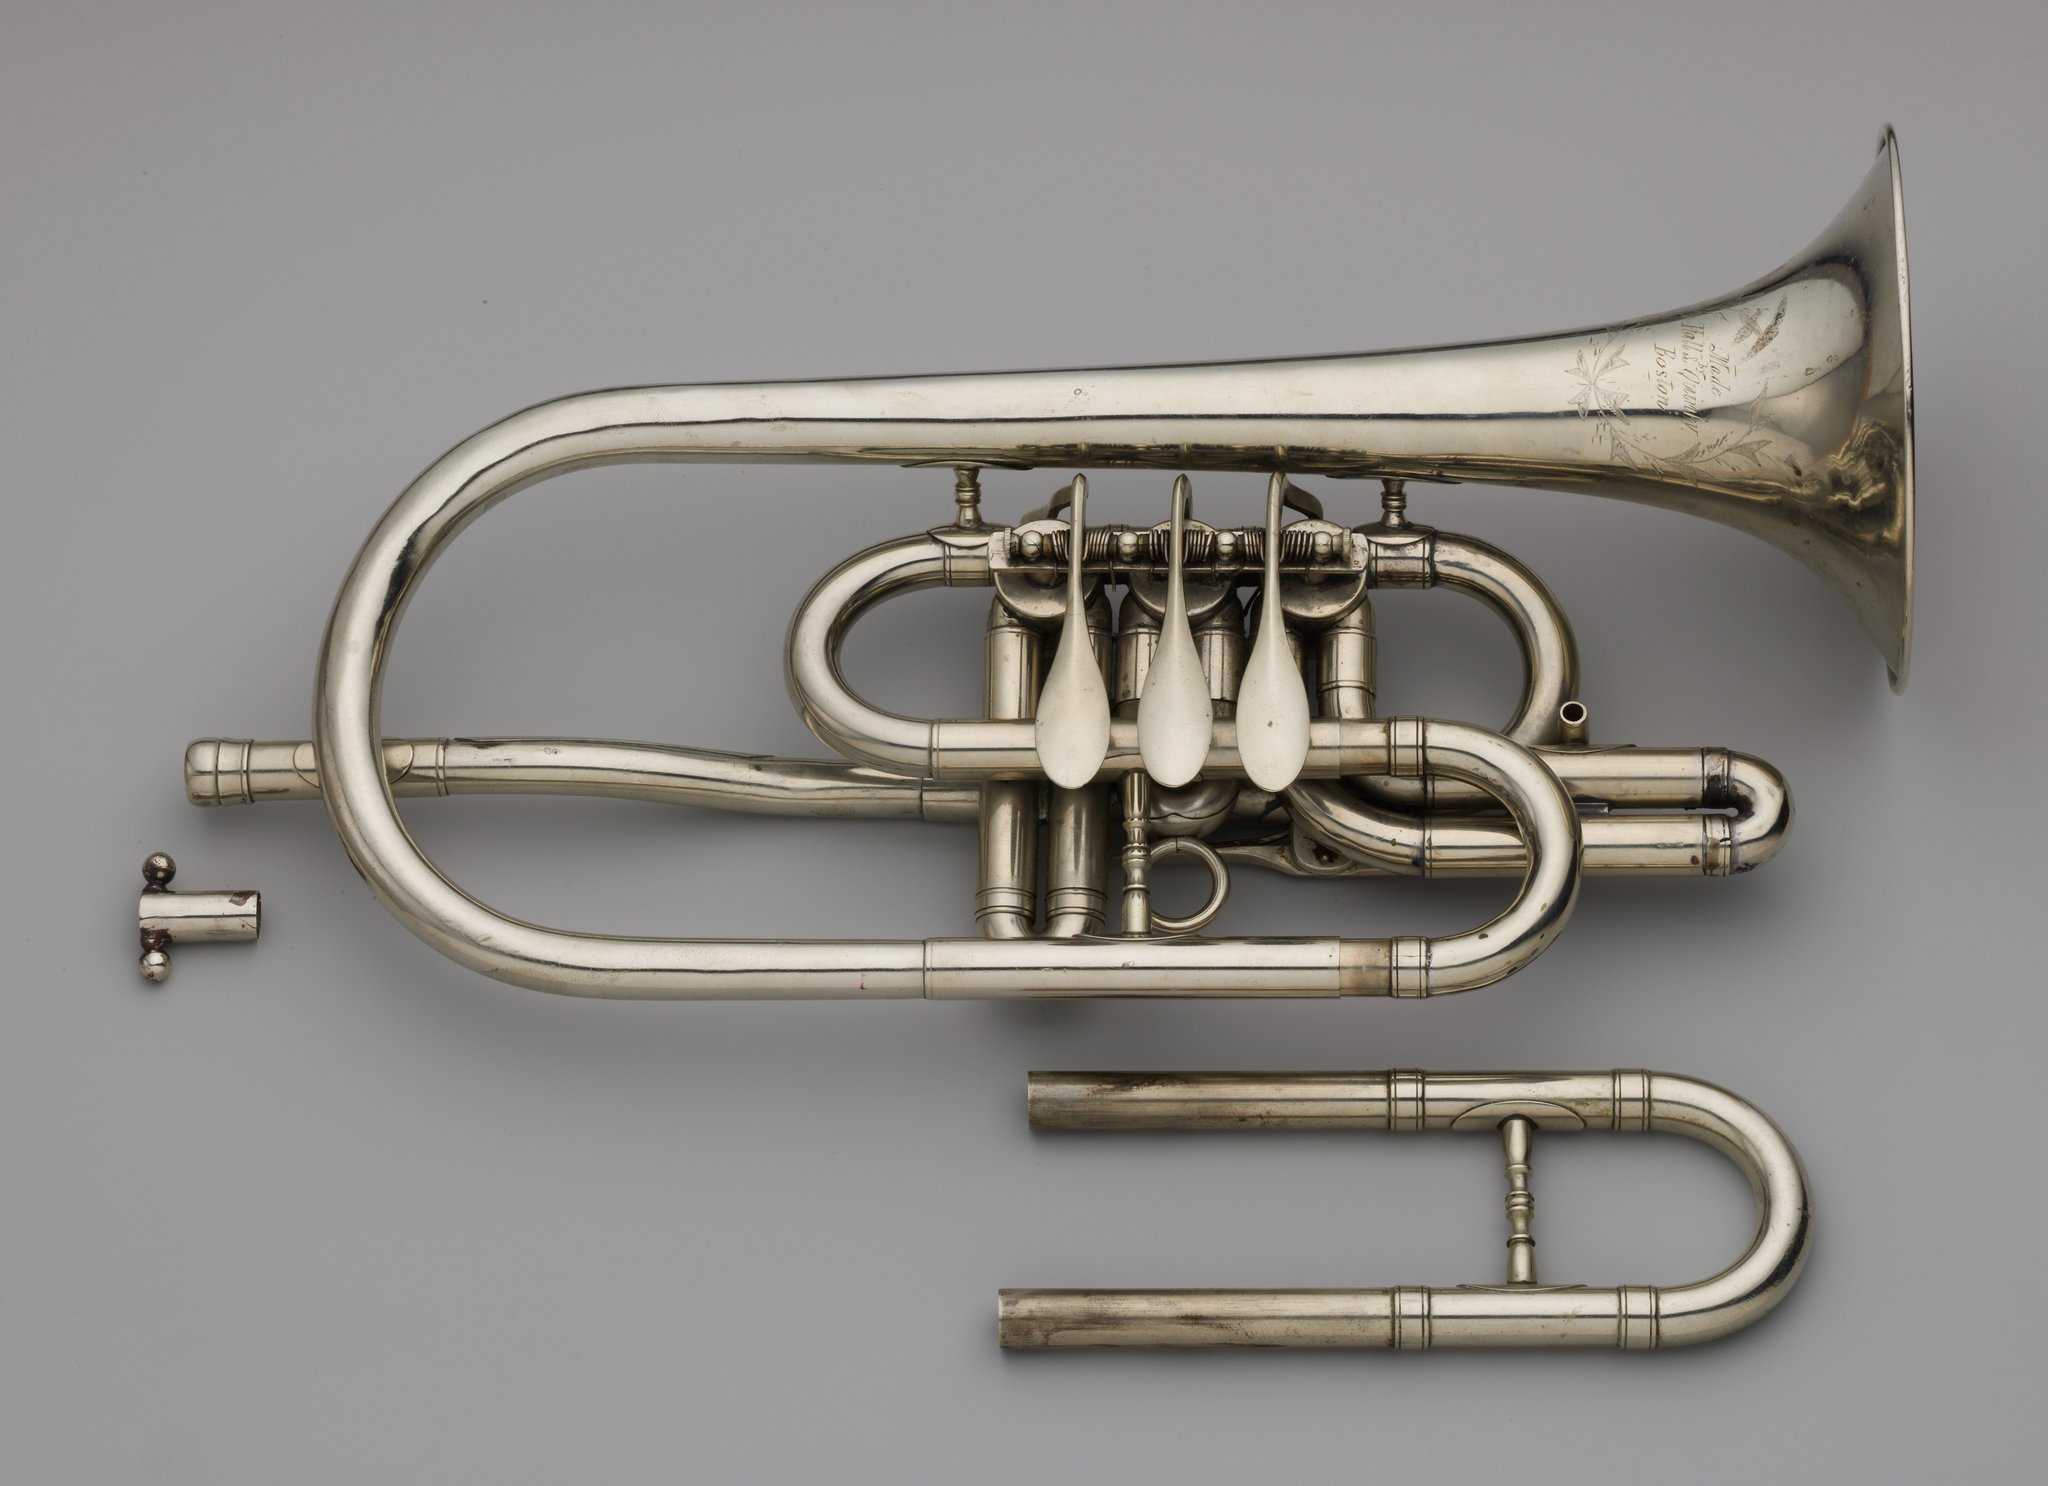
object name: rotary valve cornet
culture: american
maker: hall & quinby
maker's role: maker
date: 1870-1875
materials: metal, silver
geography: united states